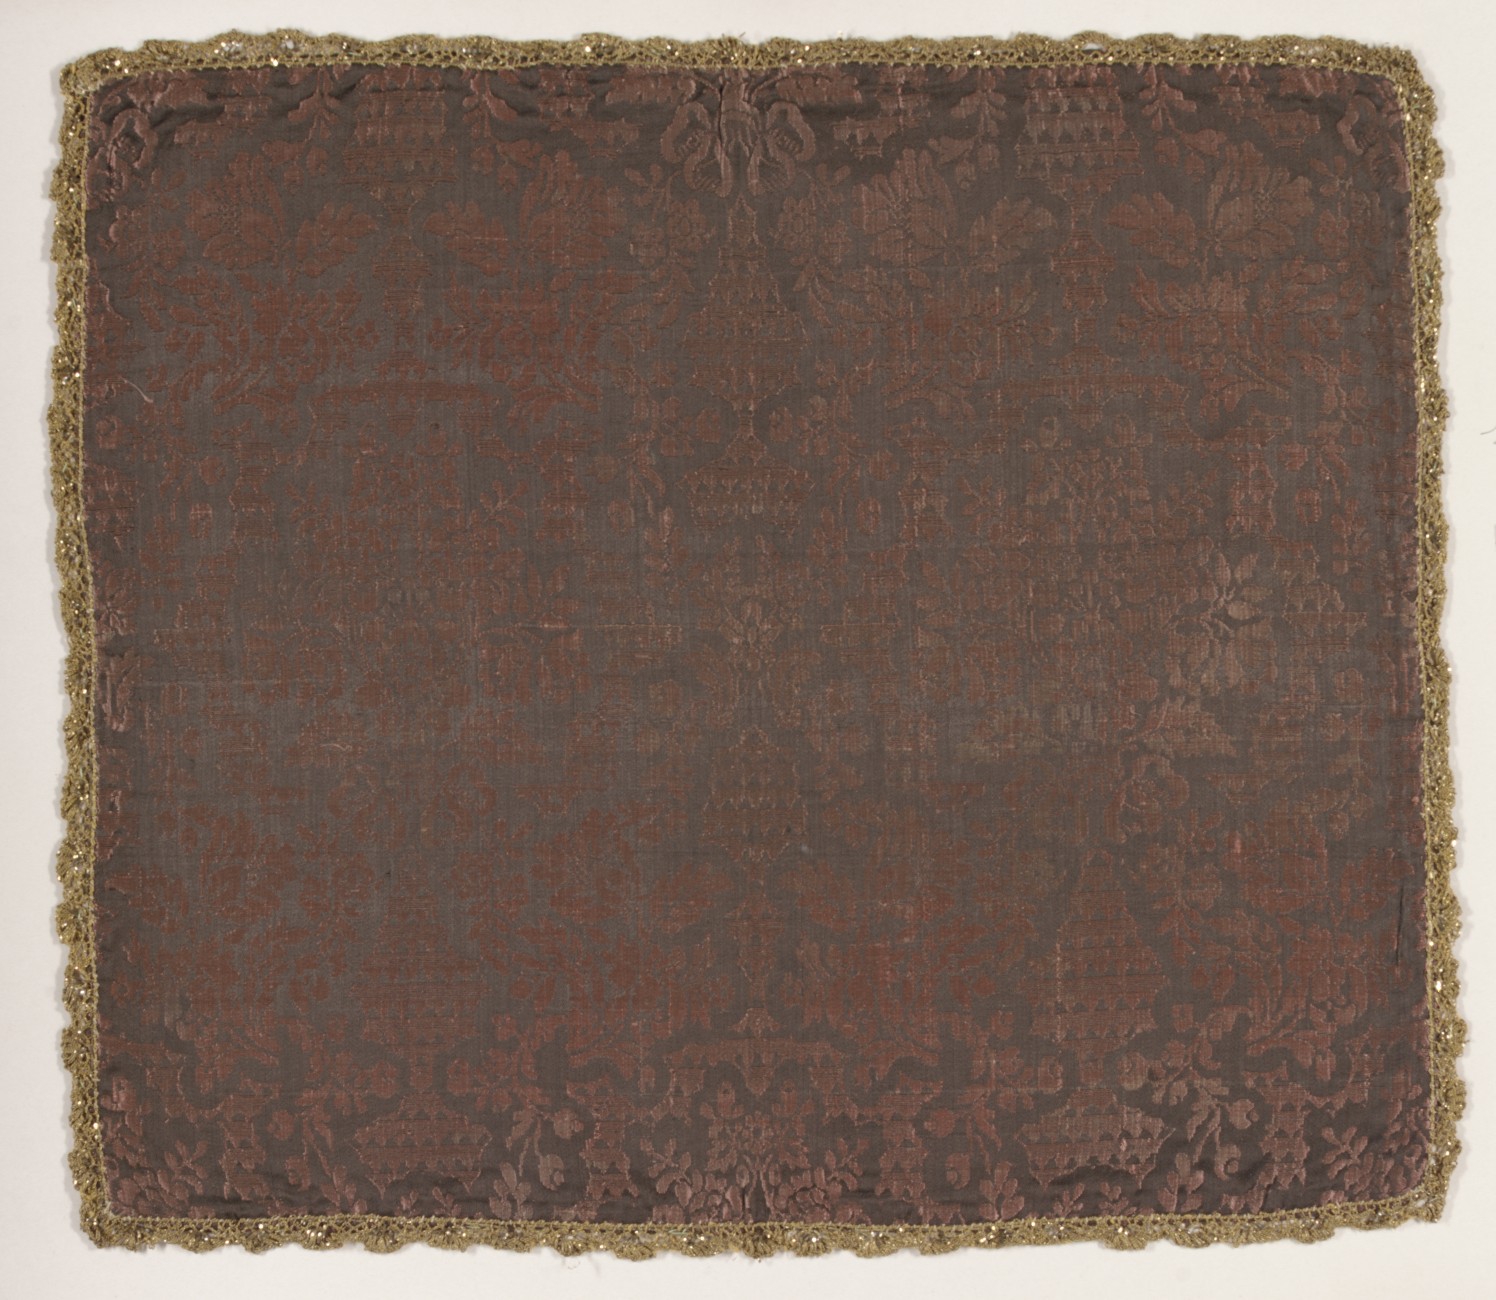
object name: fragment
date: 1701-1800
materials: metal thread, silk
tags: flowers,leaves